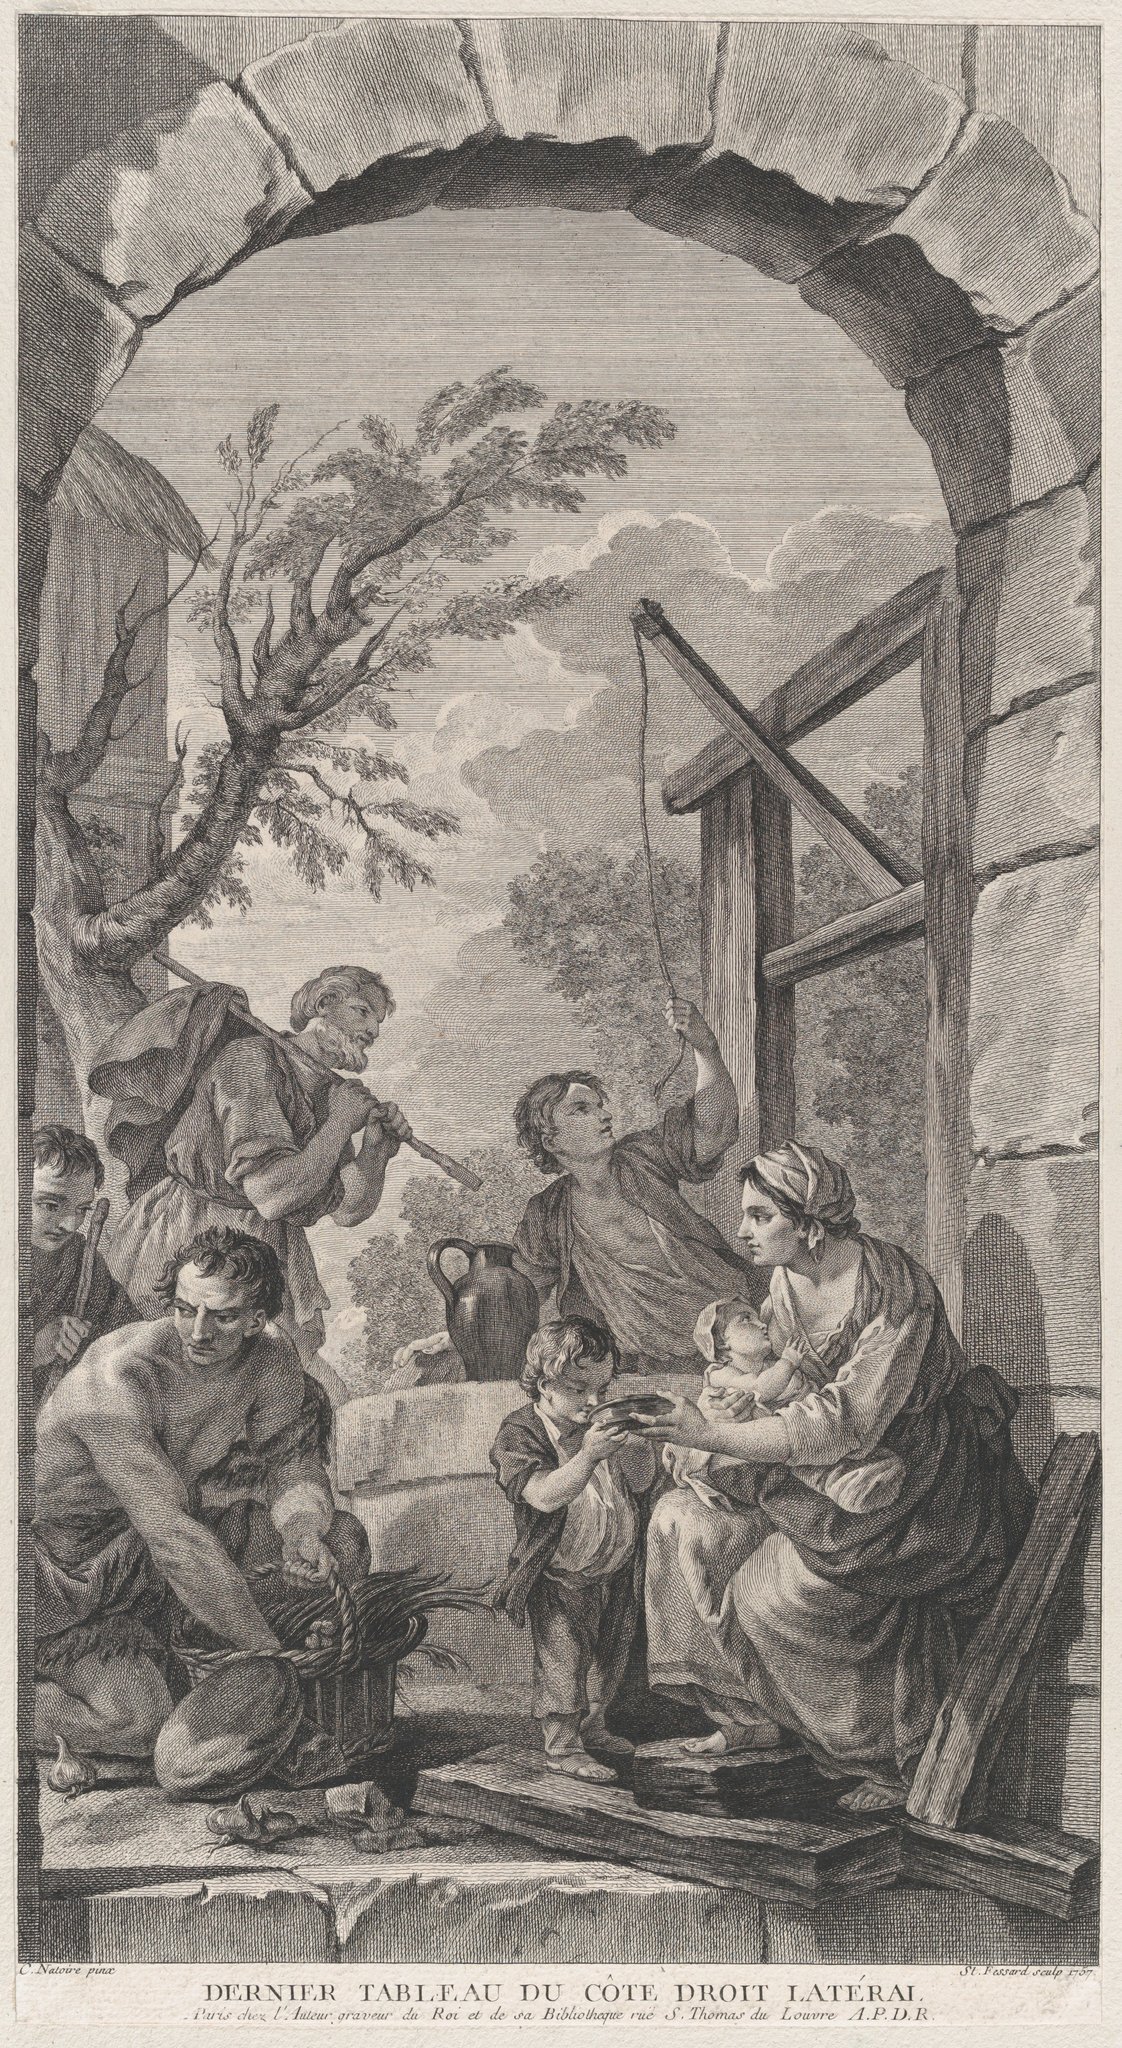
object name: print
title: The Chapel of the Enfants-Trouvés in Paris: Groupe des bergers près d'un puits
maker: etienne fessard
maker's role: artist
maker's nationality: french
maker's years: 1714-1777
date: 1757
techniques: engraving, etching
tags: boys,infants,men,women,nursing